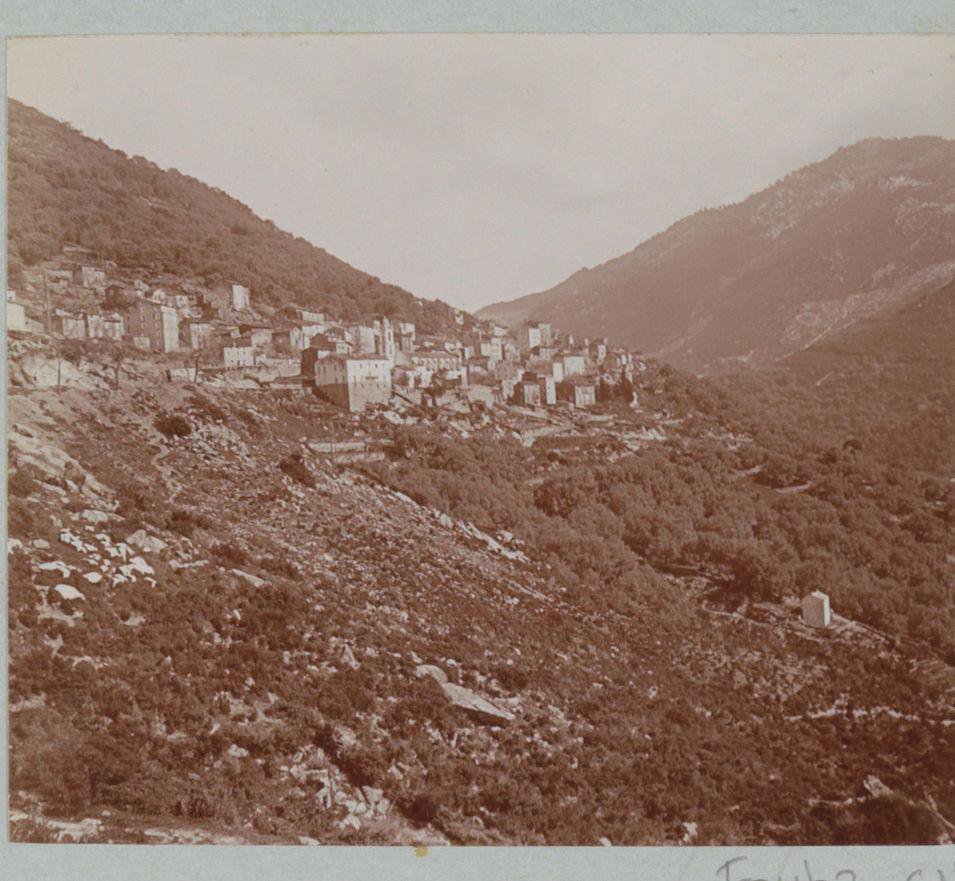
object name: photograph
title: Gezicht op een bergdorp, vermoedelijk op Corsica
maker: Anonymous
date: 1905-1910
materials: paper, photographic support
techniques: gelatin silver print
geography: corsica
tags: prospect of village, silhouette of village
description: Onderdeel van Fotoalbum van een Franse amateurfotograaf met bezienswaardigheden in Frankrijk, Zwitserland en Italië.